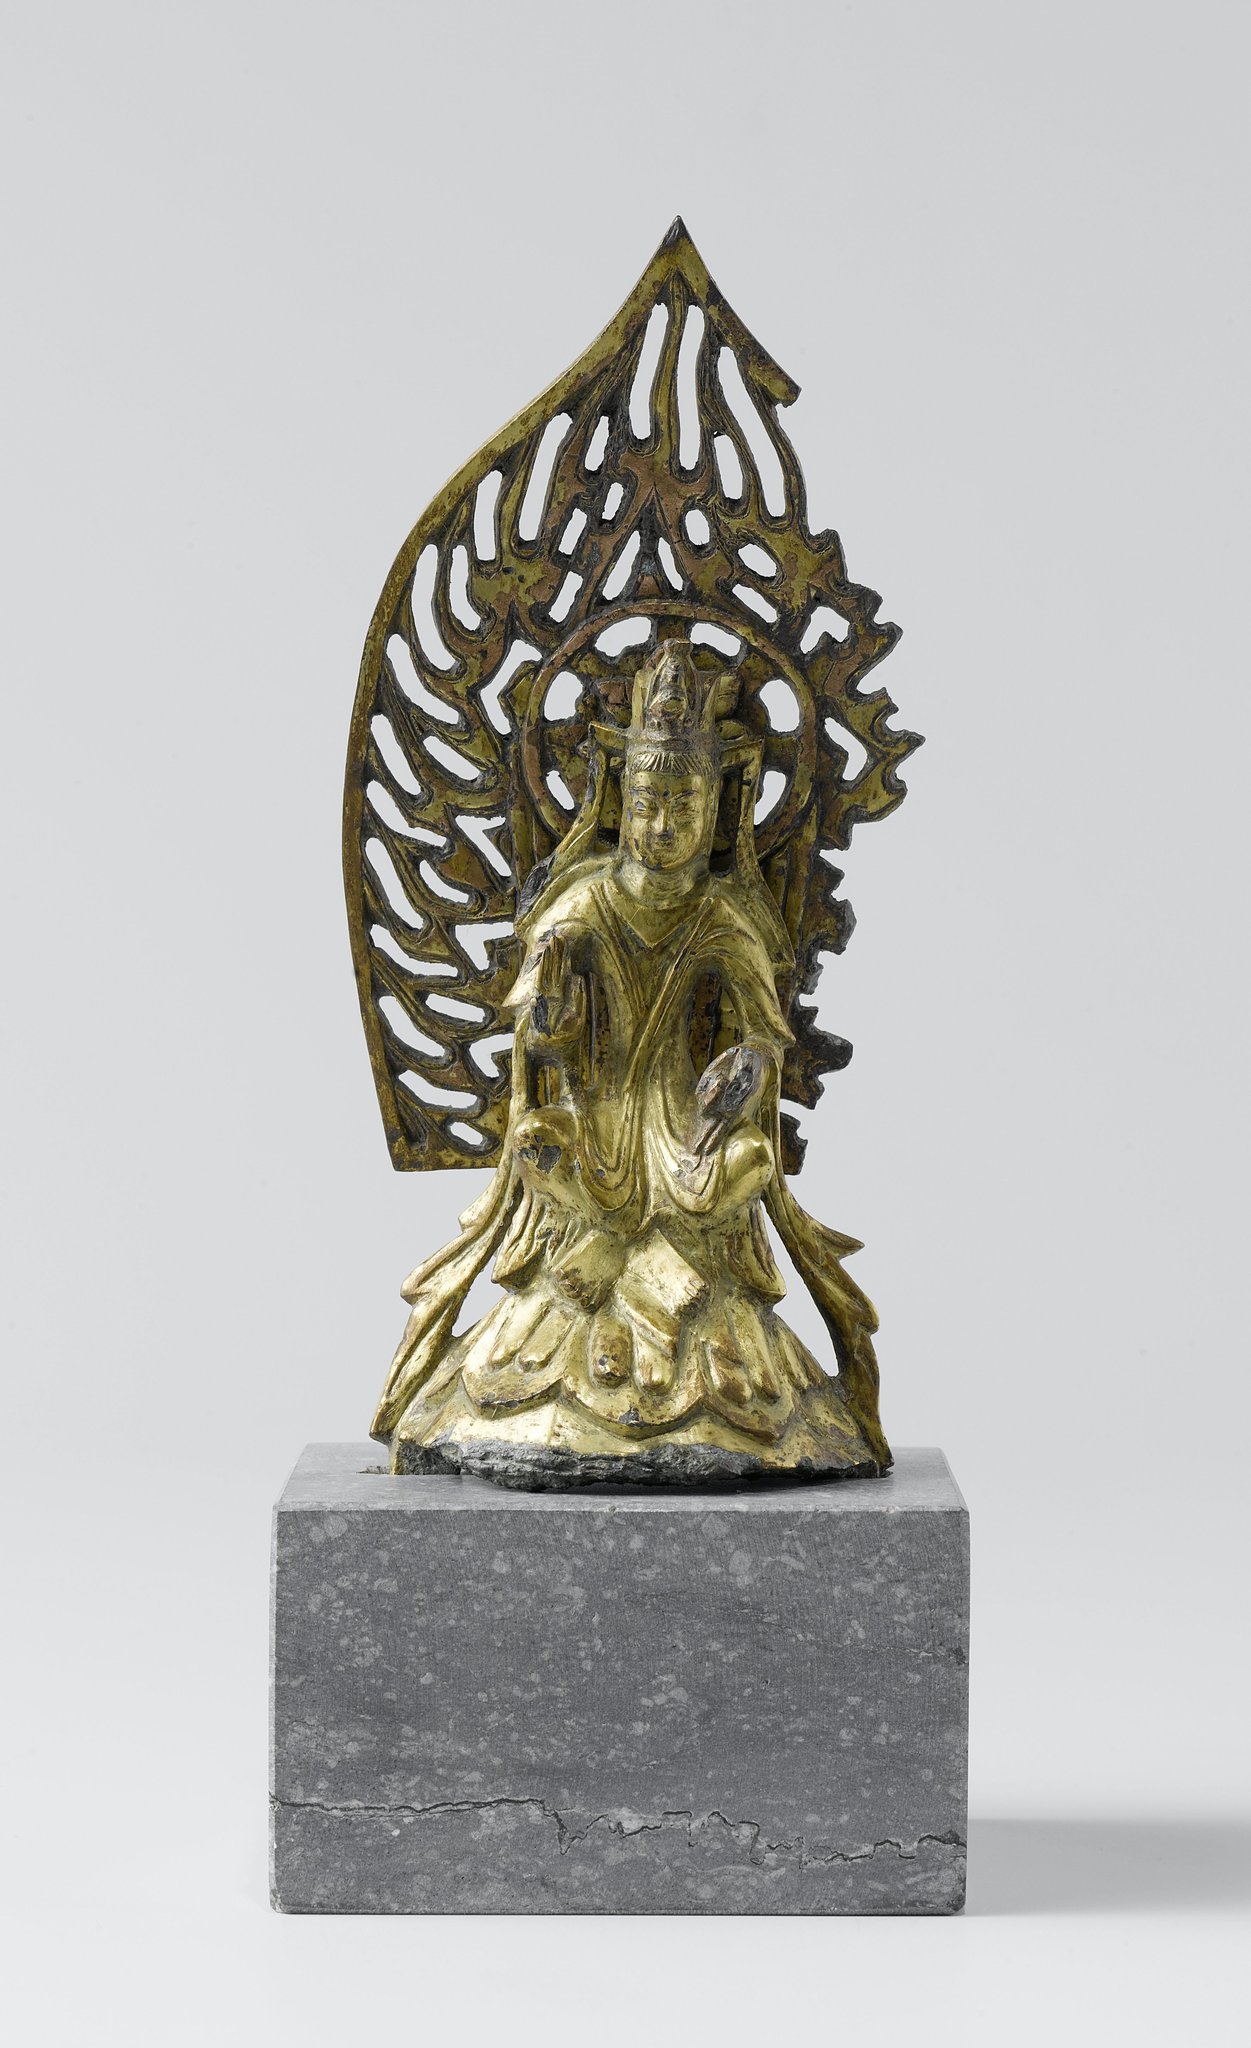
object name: figure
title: The bodhisattva Maitreya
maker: Anonymous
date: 500-525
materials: bronze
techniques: gilding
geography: china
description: Sculptures from the early 6th century are characterized by narrow waists, flat, stylized drapery folds, and angular faces, hands and feet. Later, in the brief Sui dynasty period, figures become detached from their background and are modelled in the round. They also stand upright, in a somewhat stiff and static pose.